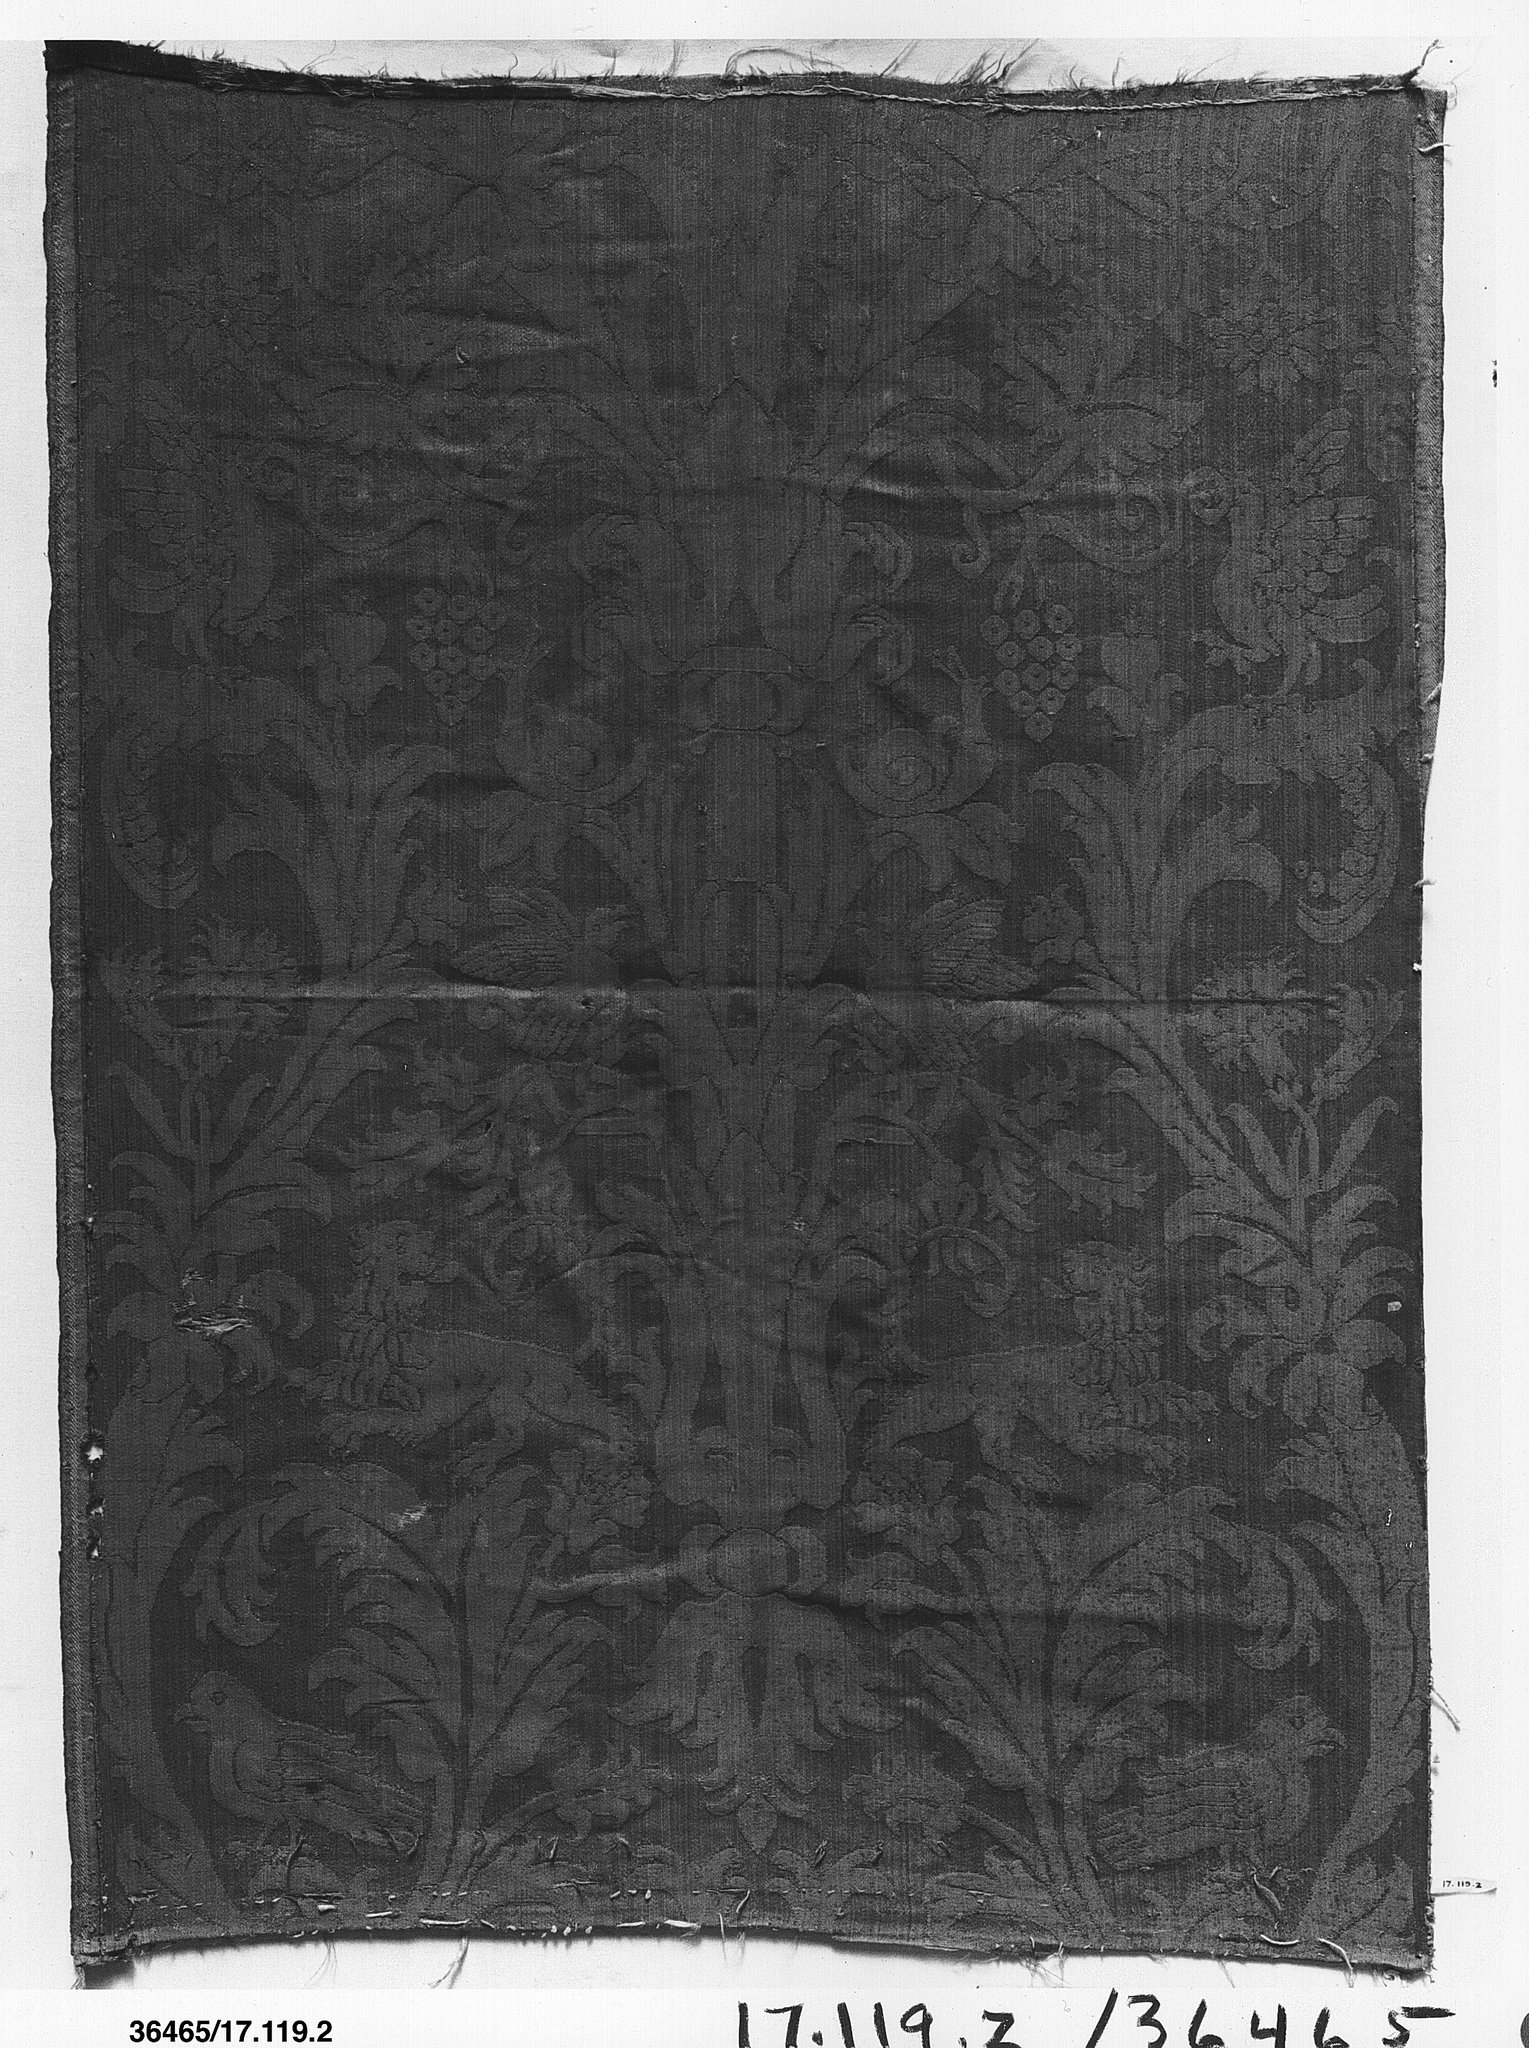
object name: piece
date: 1501-1600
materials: silk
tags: birds,lions,flowers,leaves